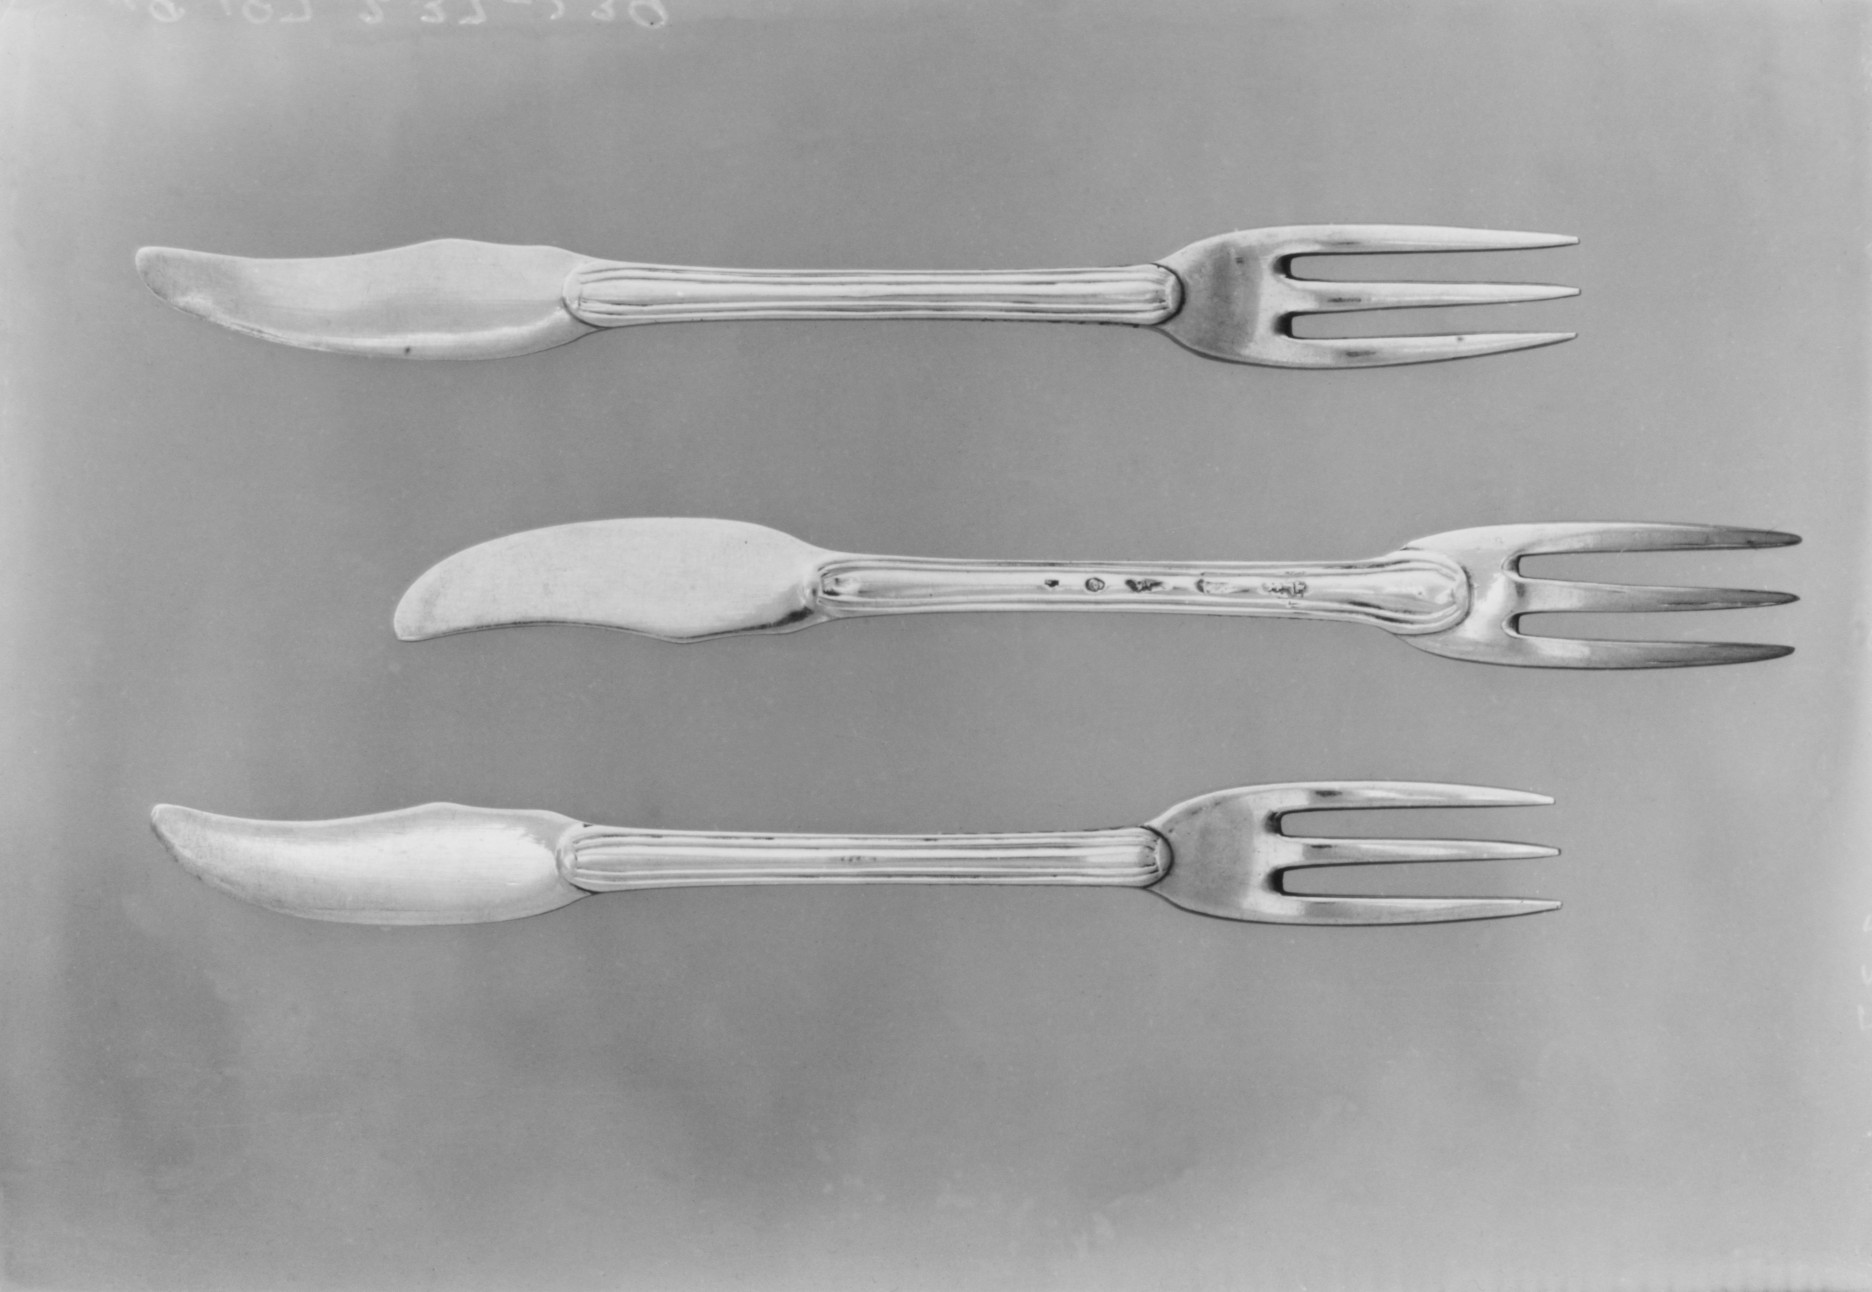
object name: fork with knife handle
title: Fork with knife handle (one of six)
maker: louis-antoine taillepied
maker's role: maker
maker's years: 1734-1834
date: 1778-1779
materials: silver